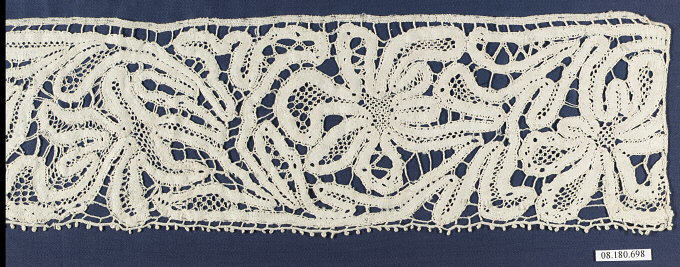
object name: fragment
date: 1701-1800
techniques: lace